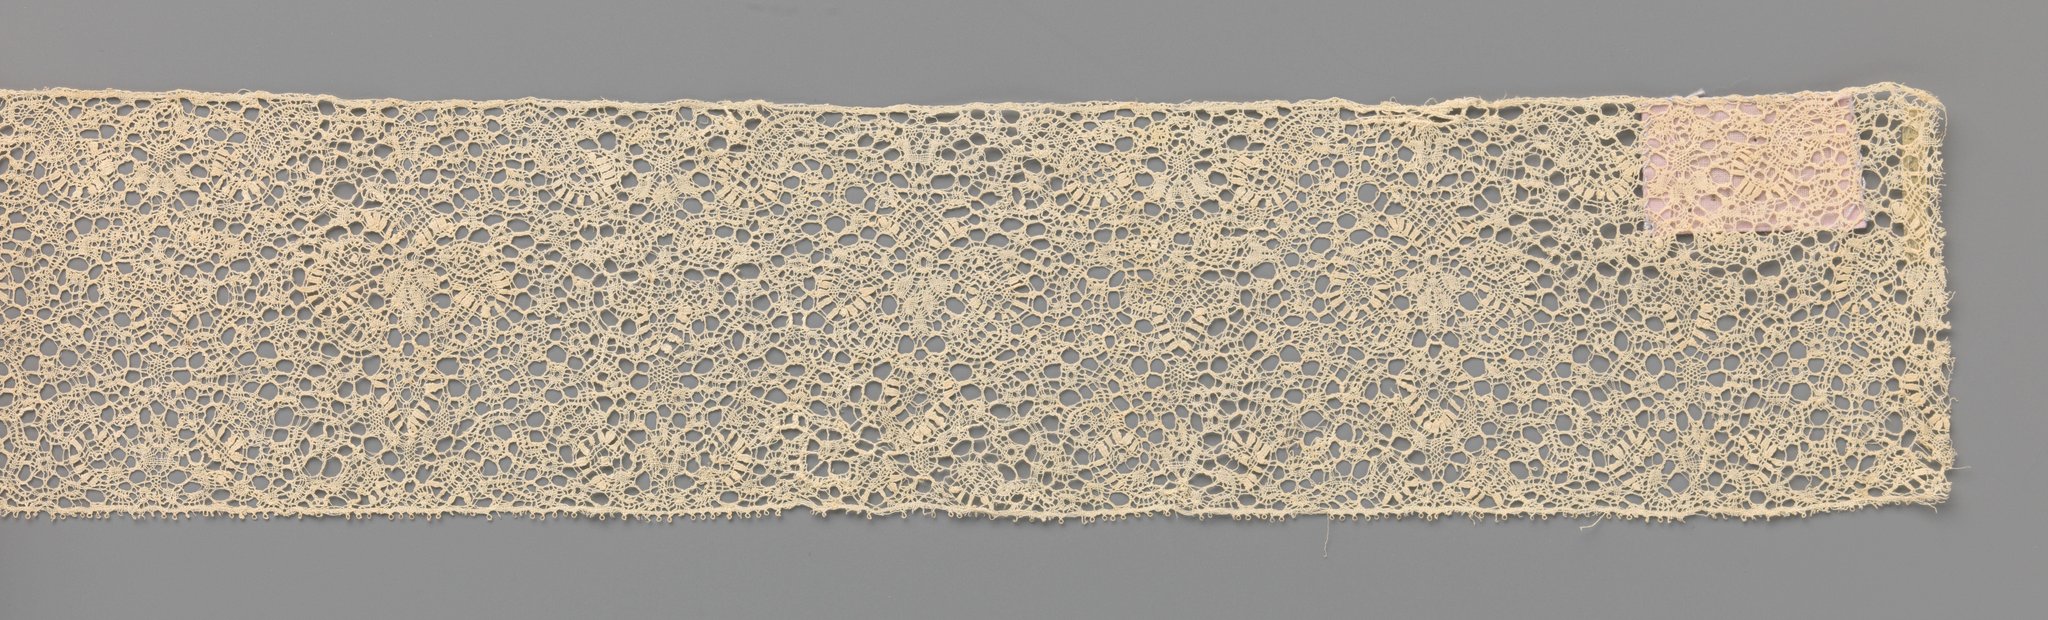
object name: strip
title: Strook kloskant met op de middenlijn takjes met vijf blaadjes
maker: Anonymous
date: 1700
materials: linen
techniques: lace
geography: southern netherlands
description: Strook naturelkleurige kloskant, Binche-kant. Het zich herhalende patroon bestaat uit wirwar van kleine motiefjes gemaakt met verschillende siergronden. Het duidelijkste motiefje in het patroon is een hangend vijfbladig takje op de middenlijn, gemaakt in linnenslag. Om het takje heen is een symmetrische schikking van vormen te zien. Aan beide zijden wordt het takje geflankeerd door drie tegen elkaar aan geplaatste ovalen, recht eronder hangt een druppelvormig motief en het takje wordt bekroond door een ruitvormig motief. De omtrekken hiervan, en van enkele andere motiefjes in het patroon, zijn geheel of gedeeltelijk benadrukt met smalle sierbandjes met rechthoekjes, gemaakt in vormslag. De motieven zijn met elkaar verbonden door een onregelmatige siergrond, een sneeuwvlokkengrond. De boven- en onderzijde van de strook zijn recht afgewerkt, waarbij de onderzijde is voorzien van picots.